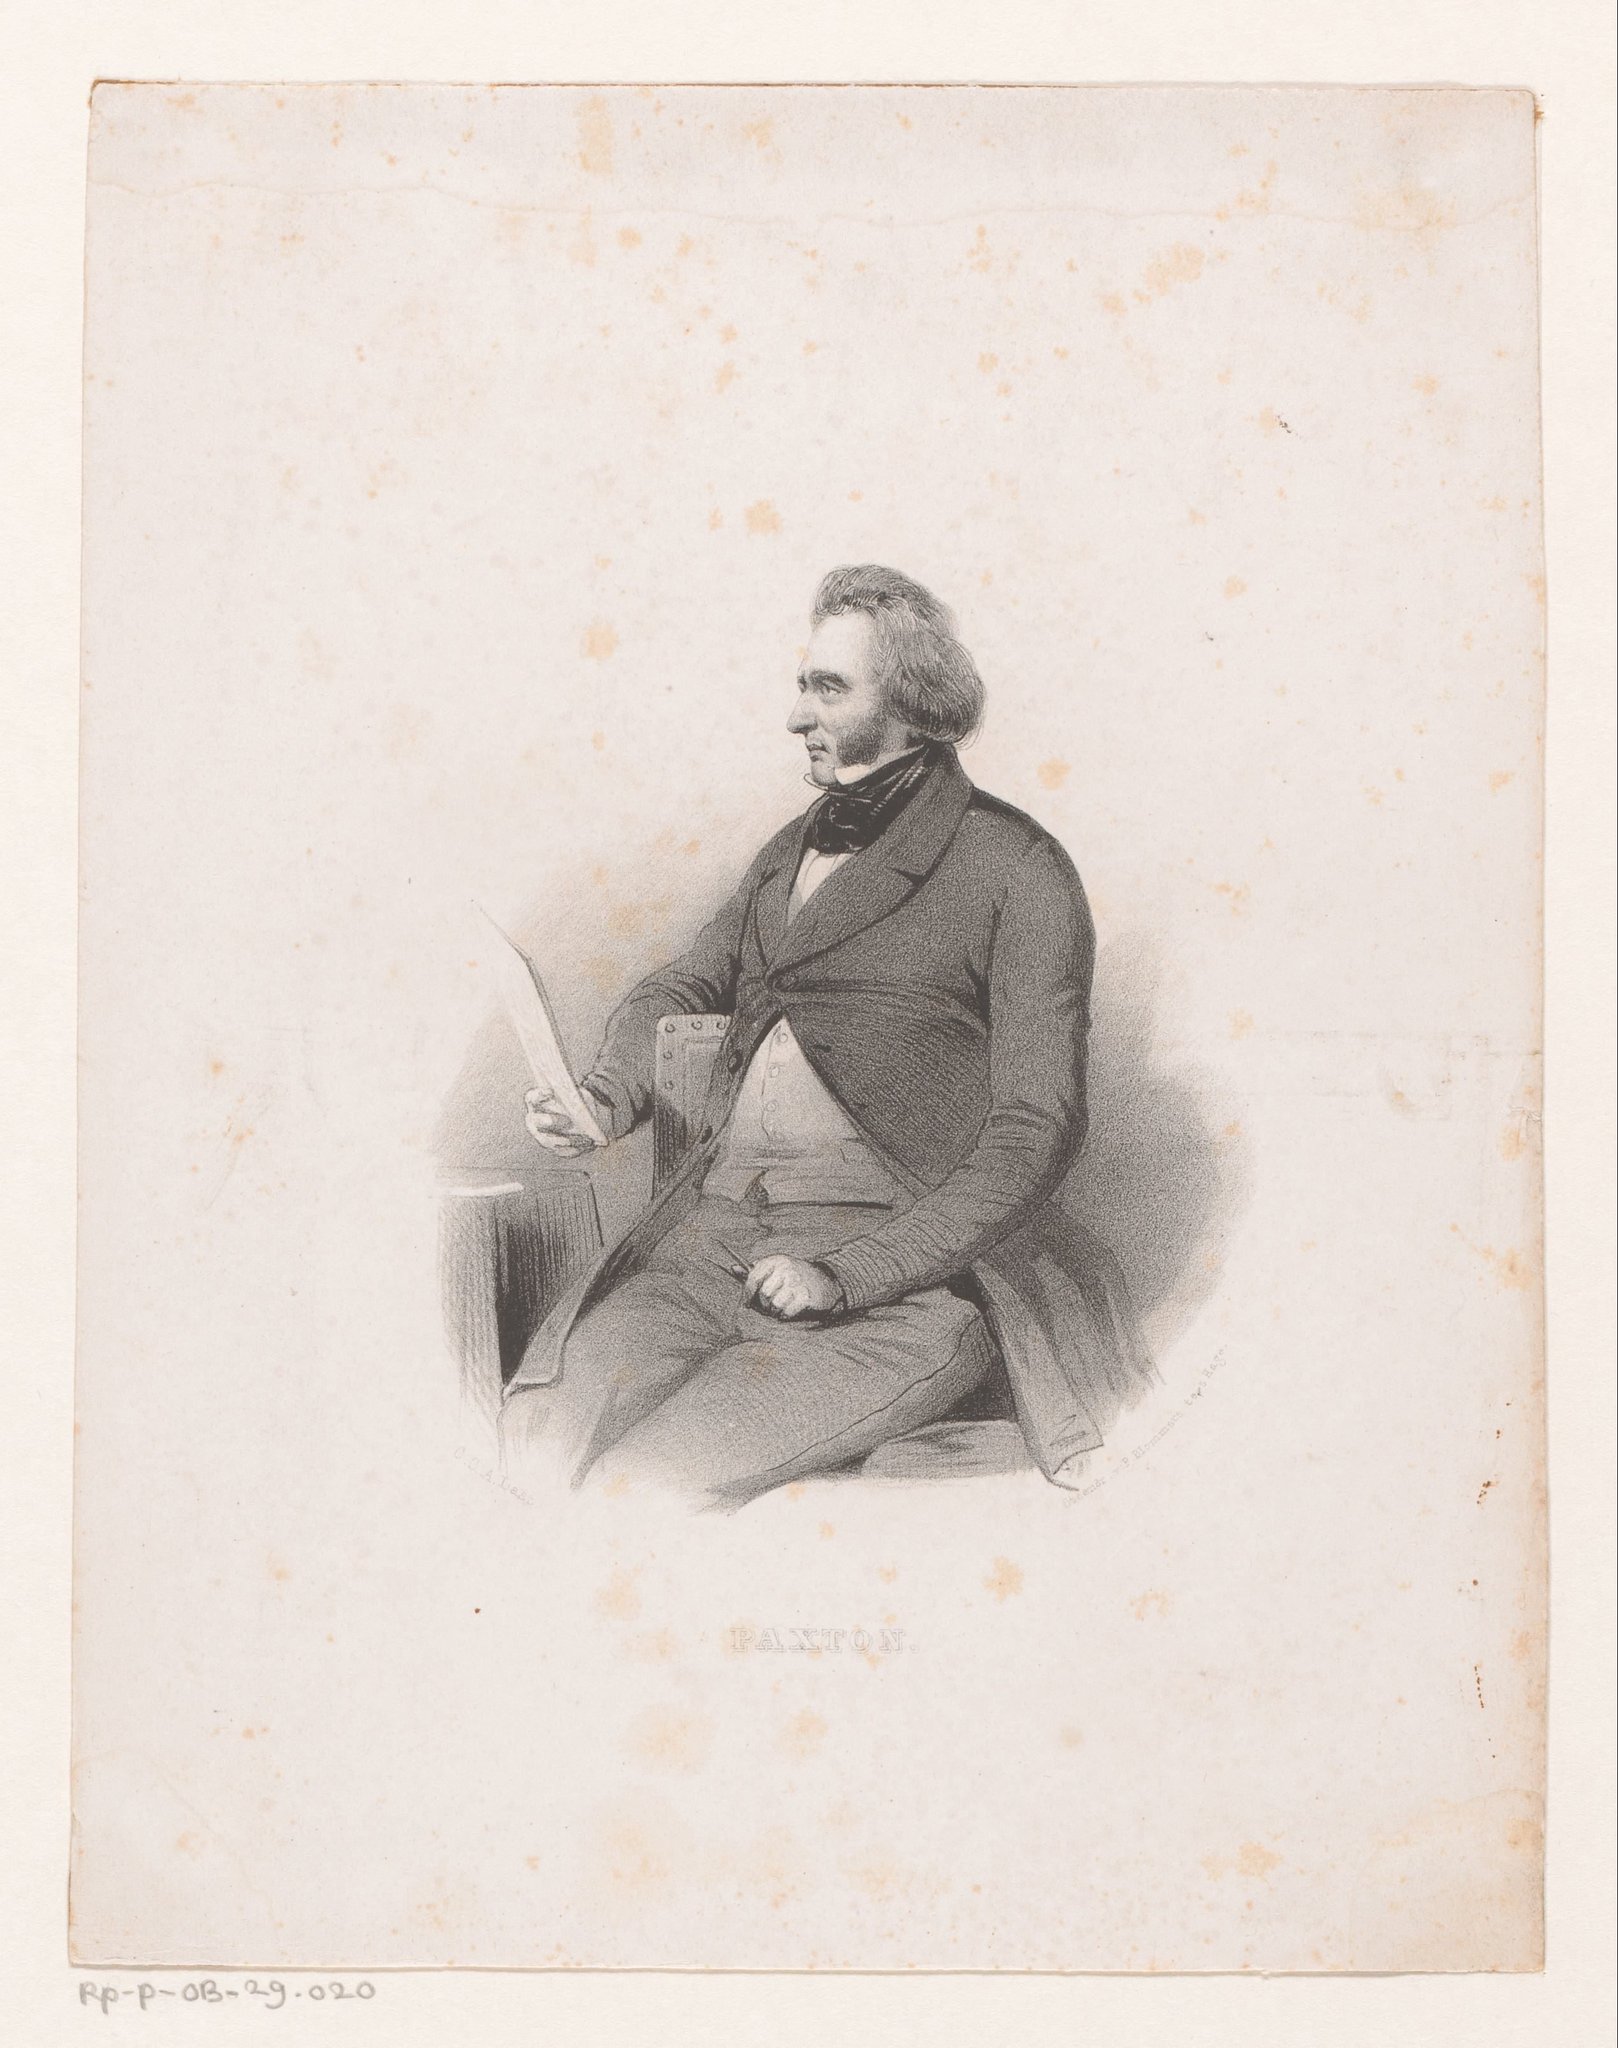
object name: print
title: Portret van Joseph Paxton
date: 1842-1887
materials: paper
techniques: lithograph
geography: the hague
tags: print maker, joseph paxton, historical persons (+ three-quarter length portrait)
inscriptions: collector's mark: Lugt 2228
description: De geportretteerde zit aan een tafel met een vel papier in zijn rechterhand.